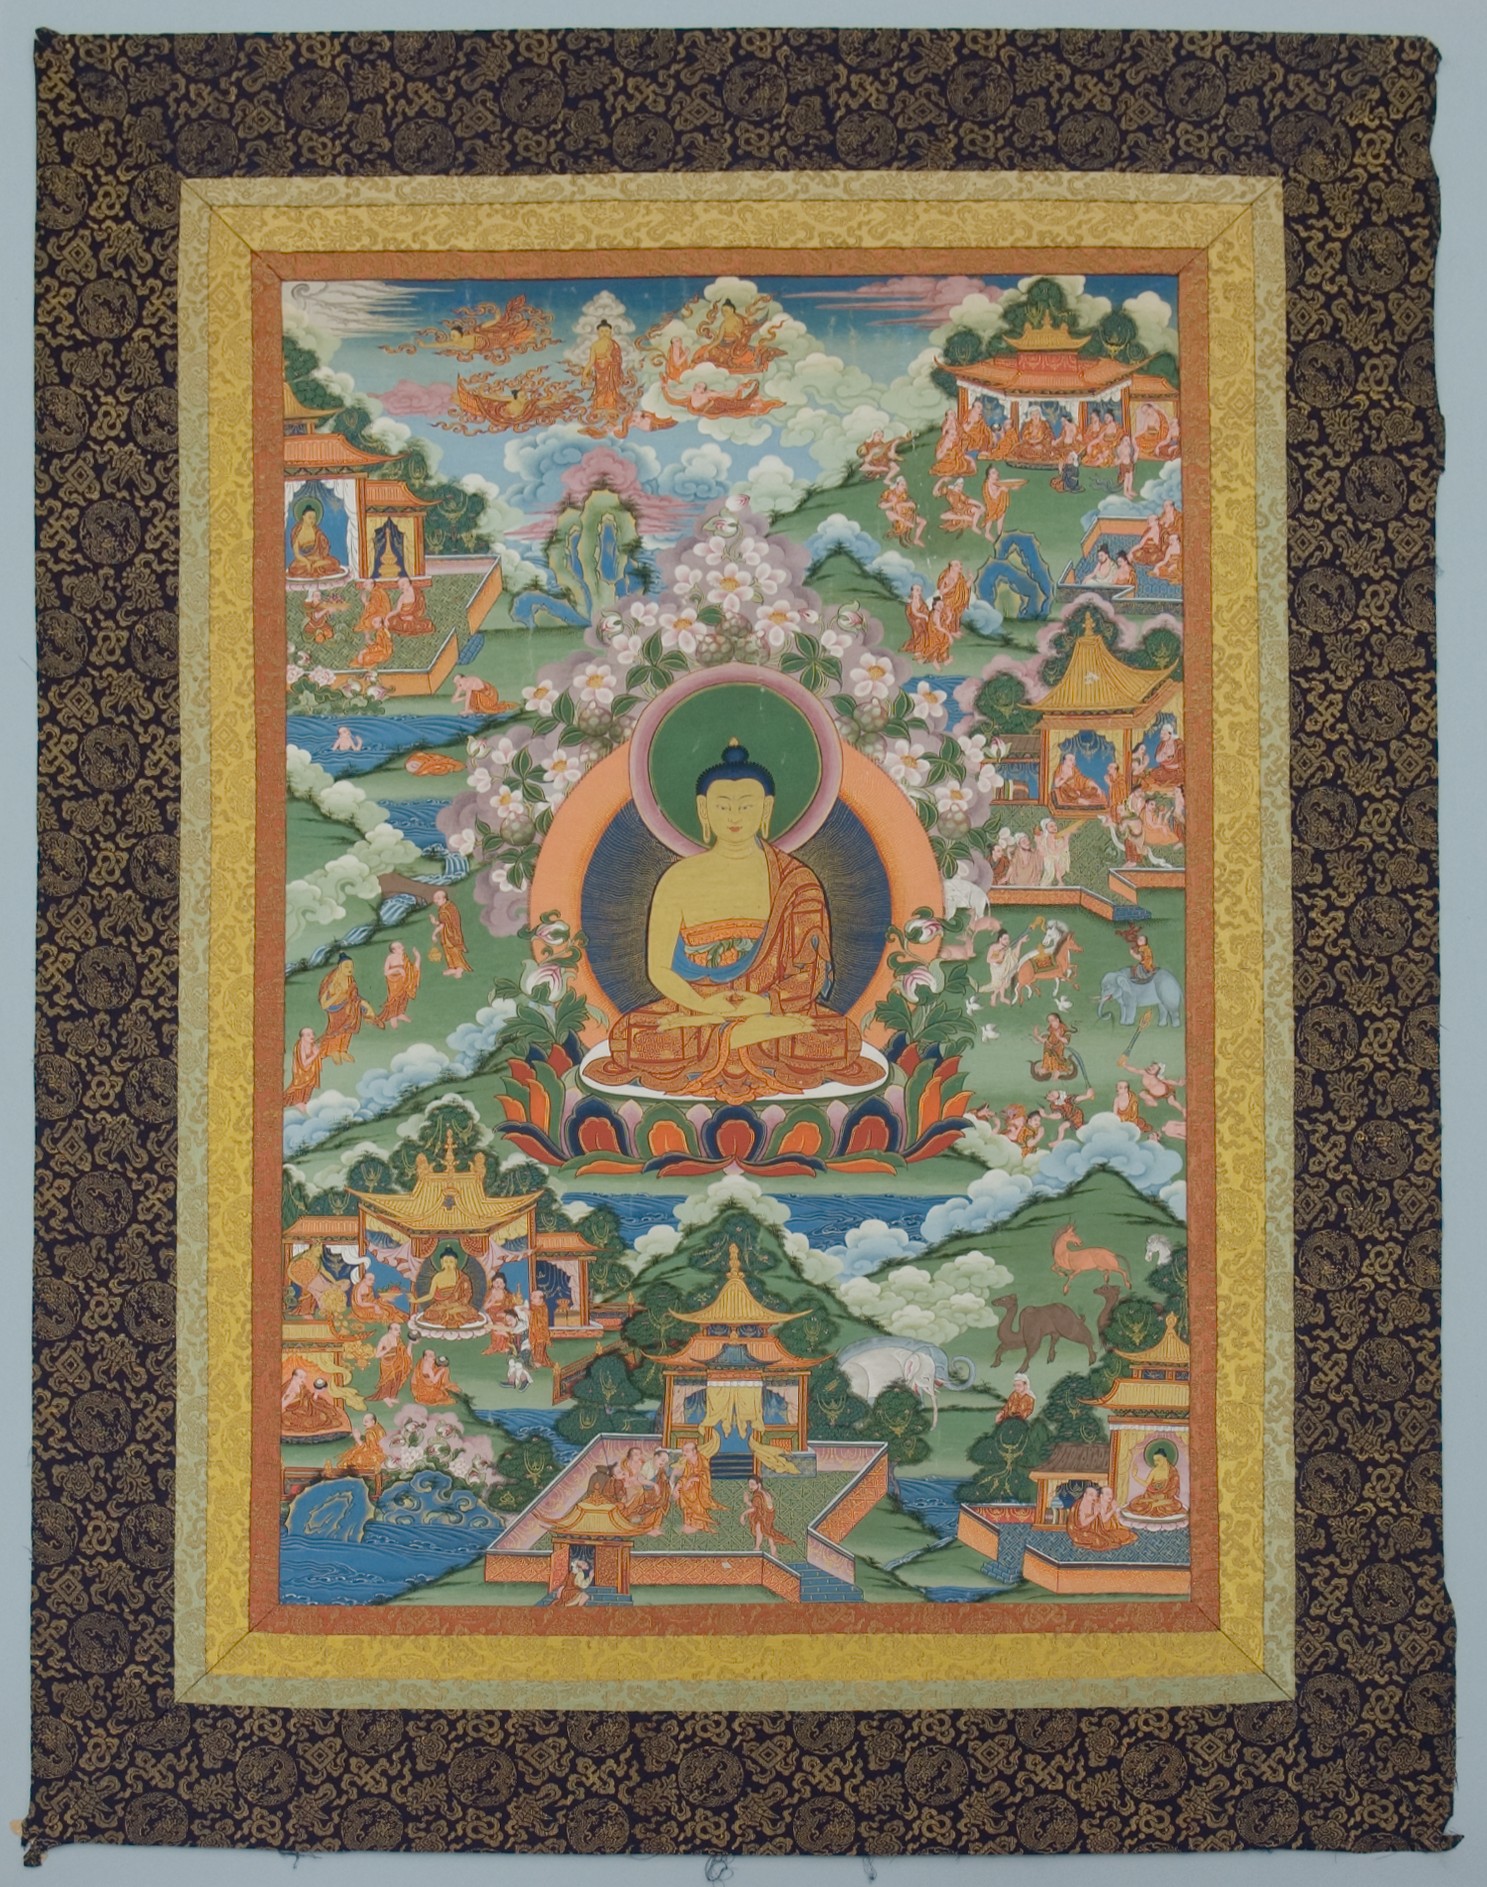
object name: thangka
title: Thangka with Buddha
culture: tibetan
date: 1801-1900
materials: textile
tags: camels,elephants,horses,buddhism,buddha,monks